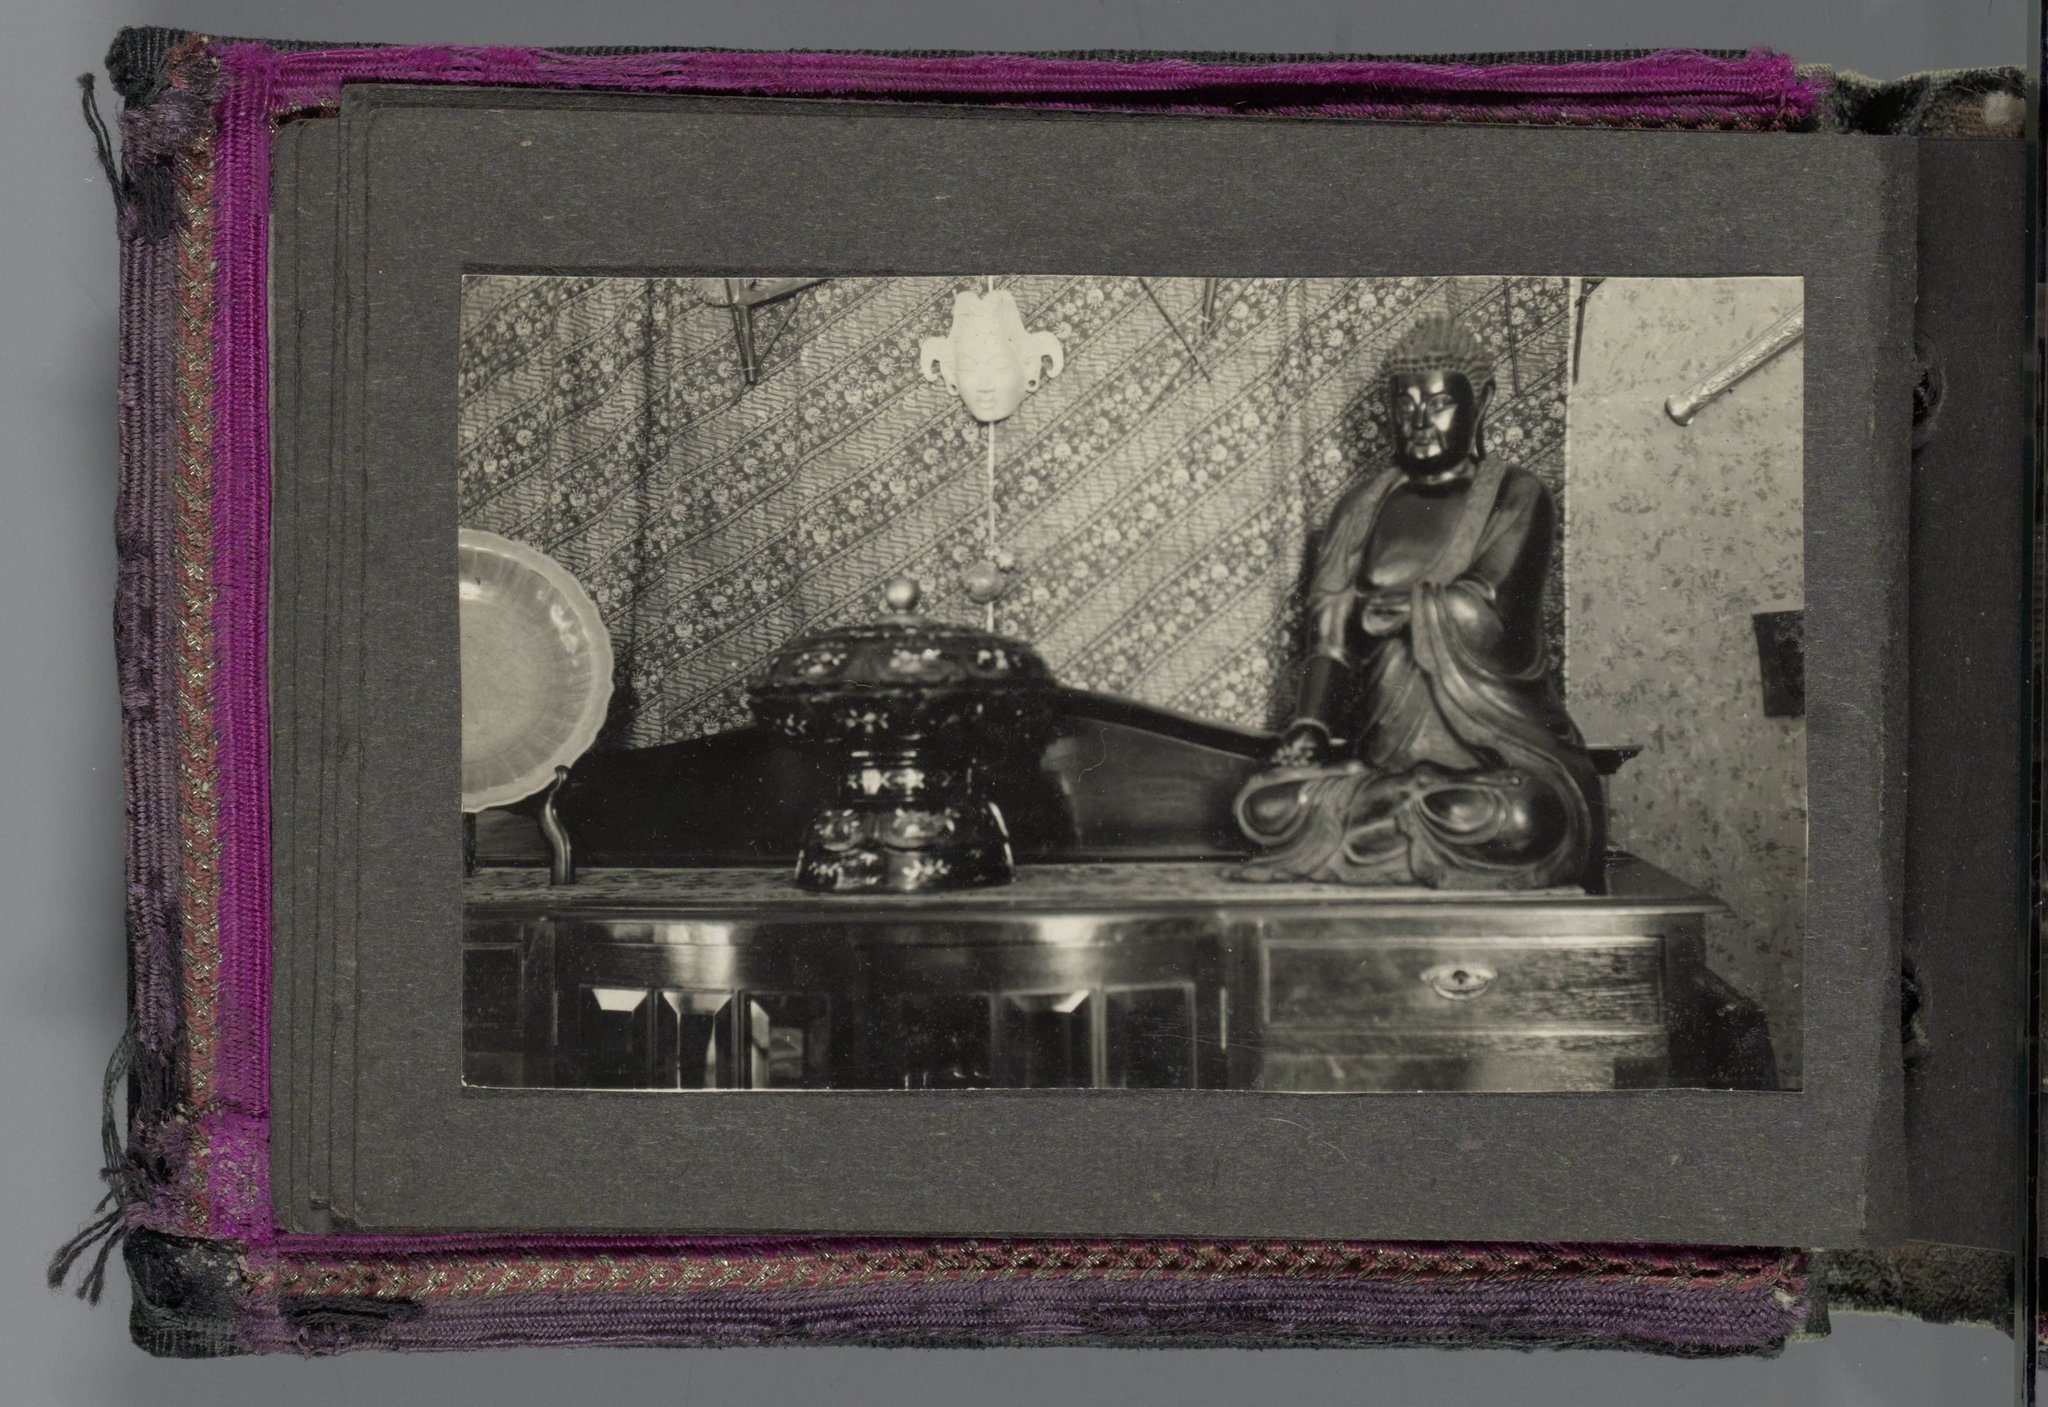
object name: photograph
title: Houtsnijwerk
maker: elsa silberstein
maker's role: amateurfotograaf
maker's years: -2006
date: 1935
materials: photographic support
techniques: gelatin silver print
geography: bandung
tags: amsterdam, elsa silberstein, interior of the house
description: De wand van een kamer versierd met een omlijsting en panelen met houtsnijwerk, links een lamp, rechts een cactus. In het woonhuis van Elsa Silberstein en haar man, thesaurier-generaal in Bandung in 1935. Schilderijtjes aan de muur. Onderdeel van het fotoalbum met zwart-wit foto's van het interieur van het huis van de familie Silberstein in Bandung in Nederlands-Indië.